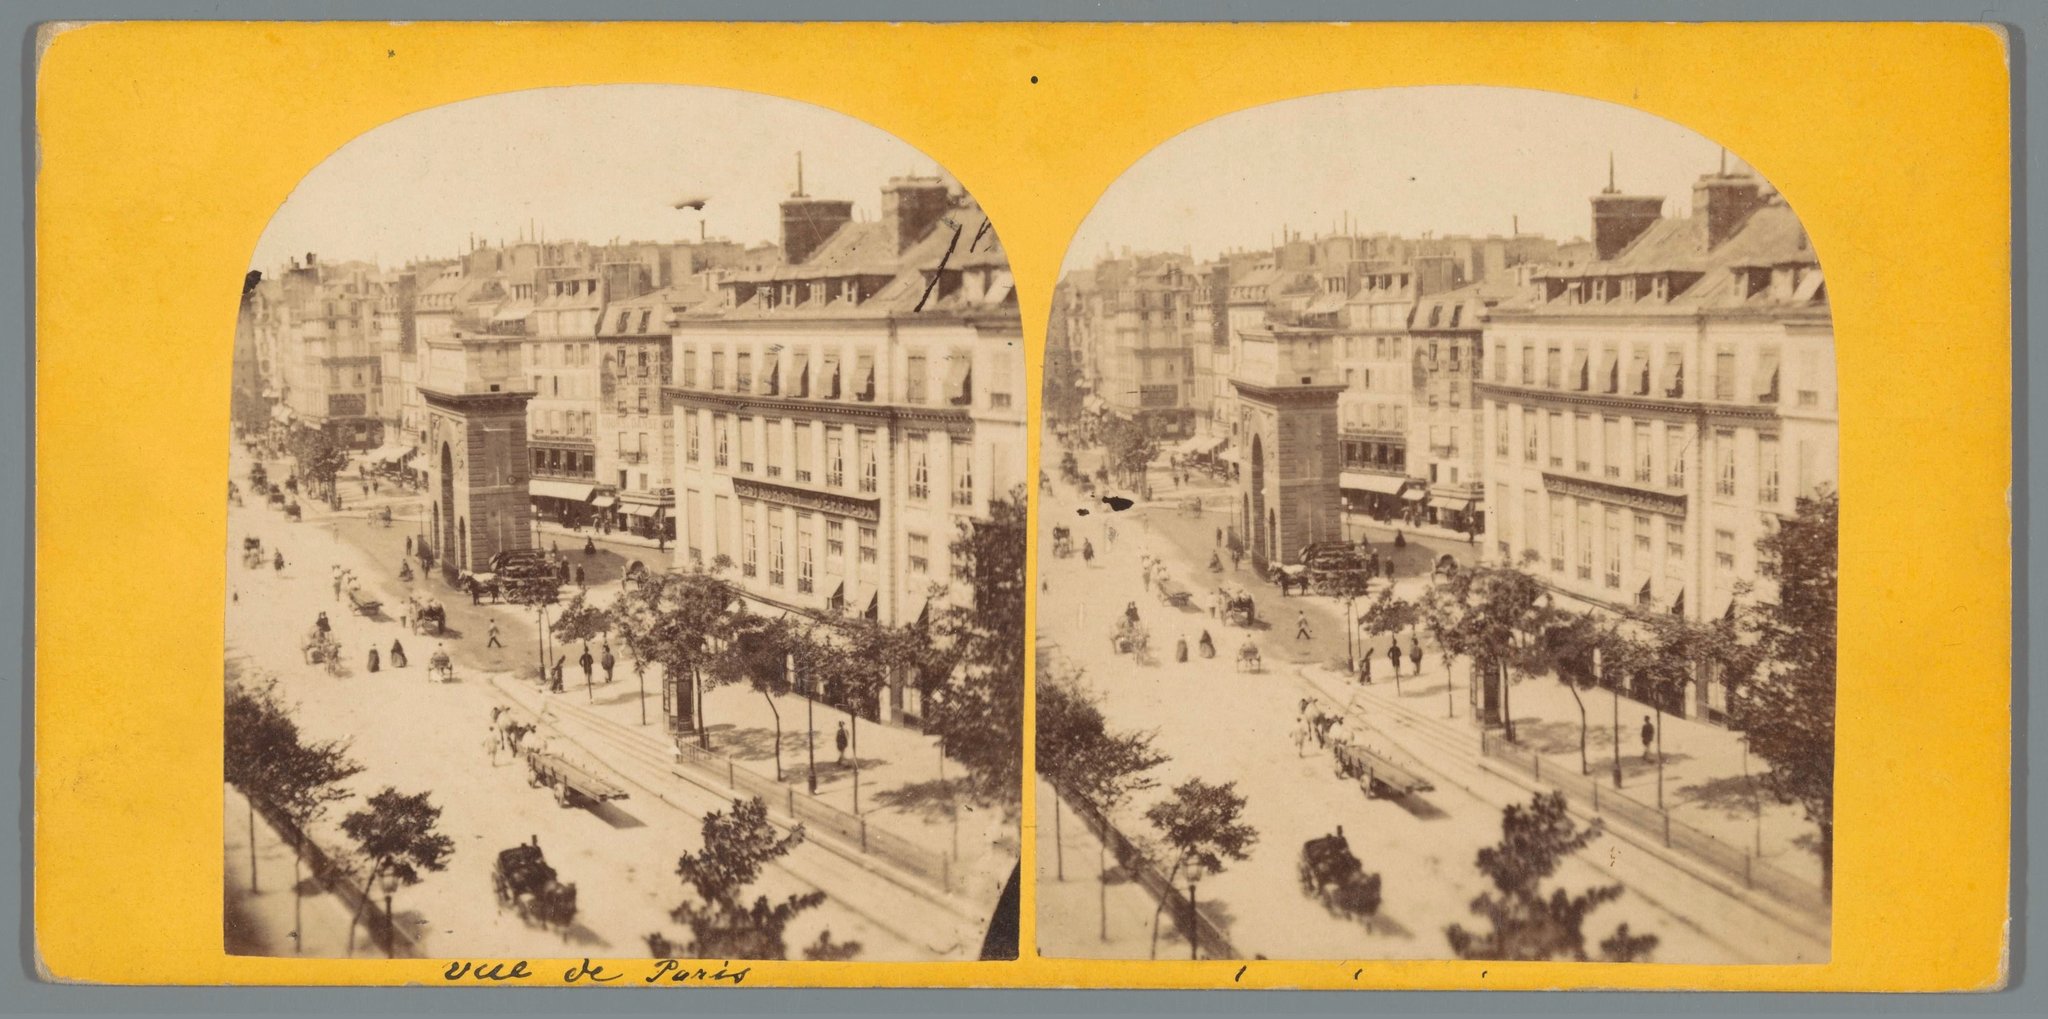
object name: stereograph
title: Gezicht op de Porte Saint-Martin en de Boulevard Saint-Martin in Parijs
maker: Anonymous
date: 1850-1880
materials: cardboard, photographic support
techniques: albumen print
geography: paris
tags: animal traction, animal-drawn vehicle (carriage etc.), street, city-gate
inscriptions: number: ‘[...] No. 14’, inscription: ‘Vue de Paris’